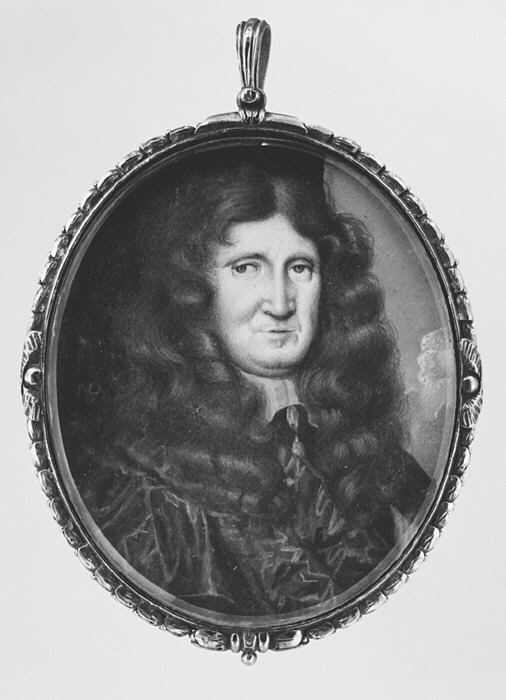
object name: painting, miniature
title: Sir Henry Blount (1602–1682)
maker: nicholas dixon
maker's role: artist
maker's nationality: british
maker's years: 1660-1708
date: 1660-1669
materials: parchment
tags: men,portraits